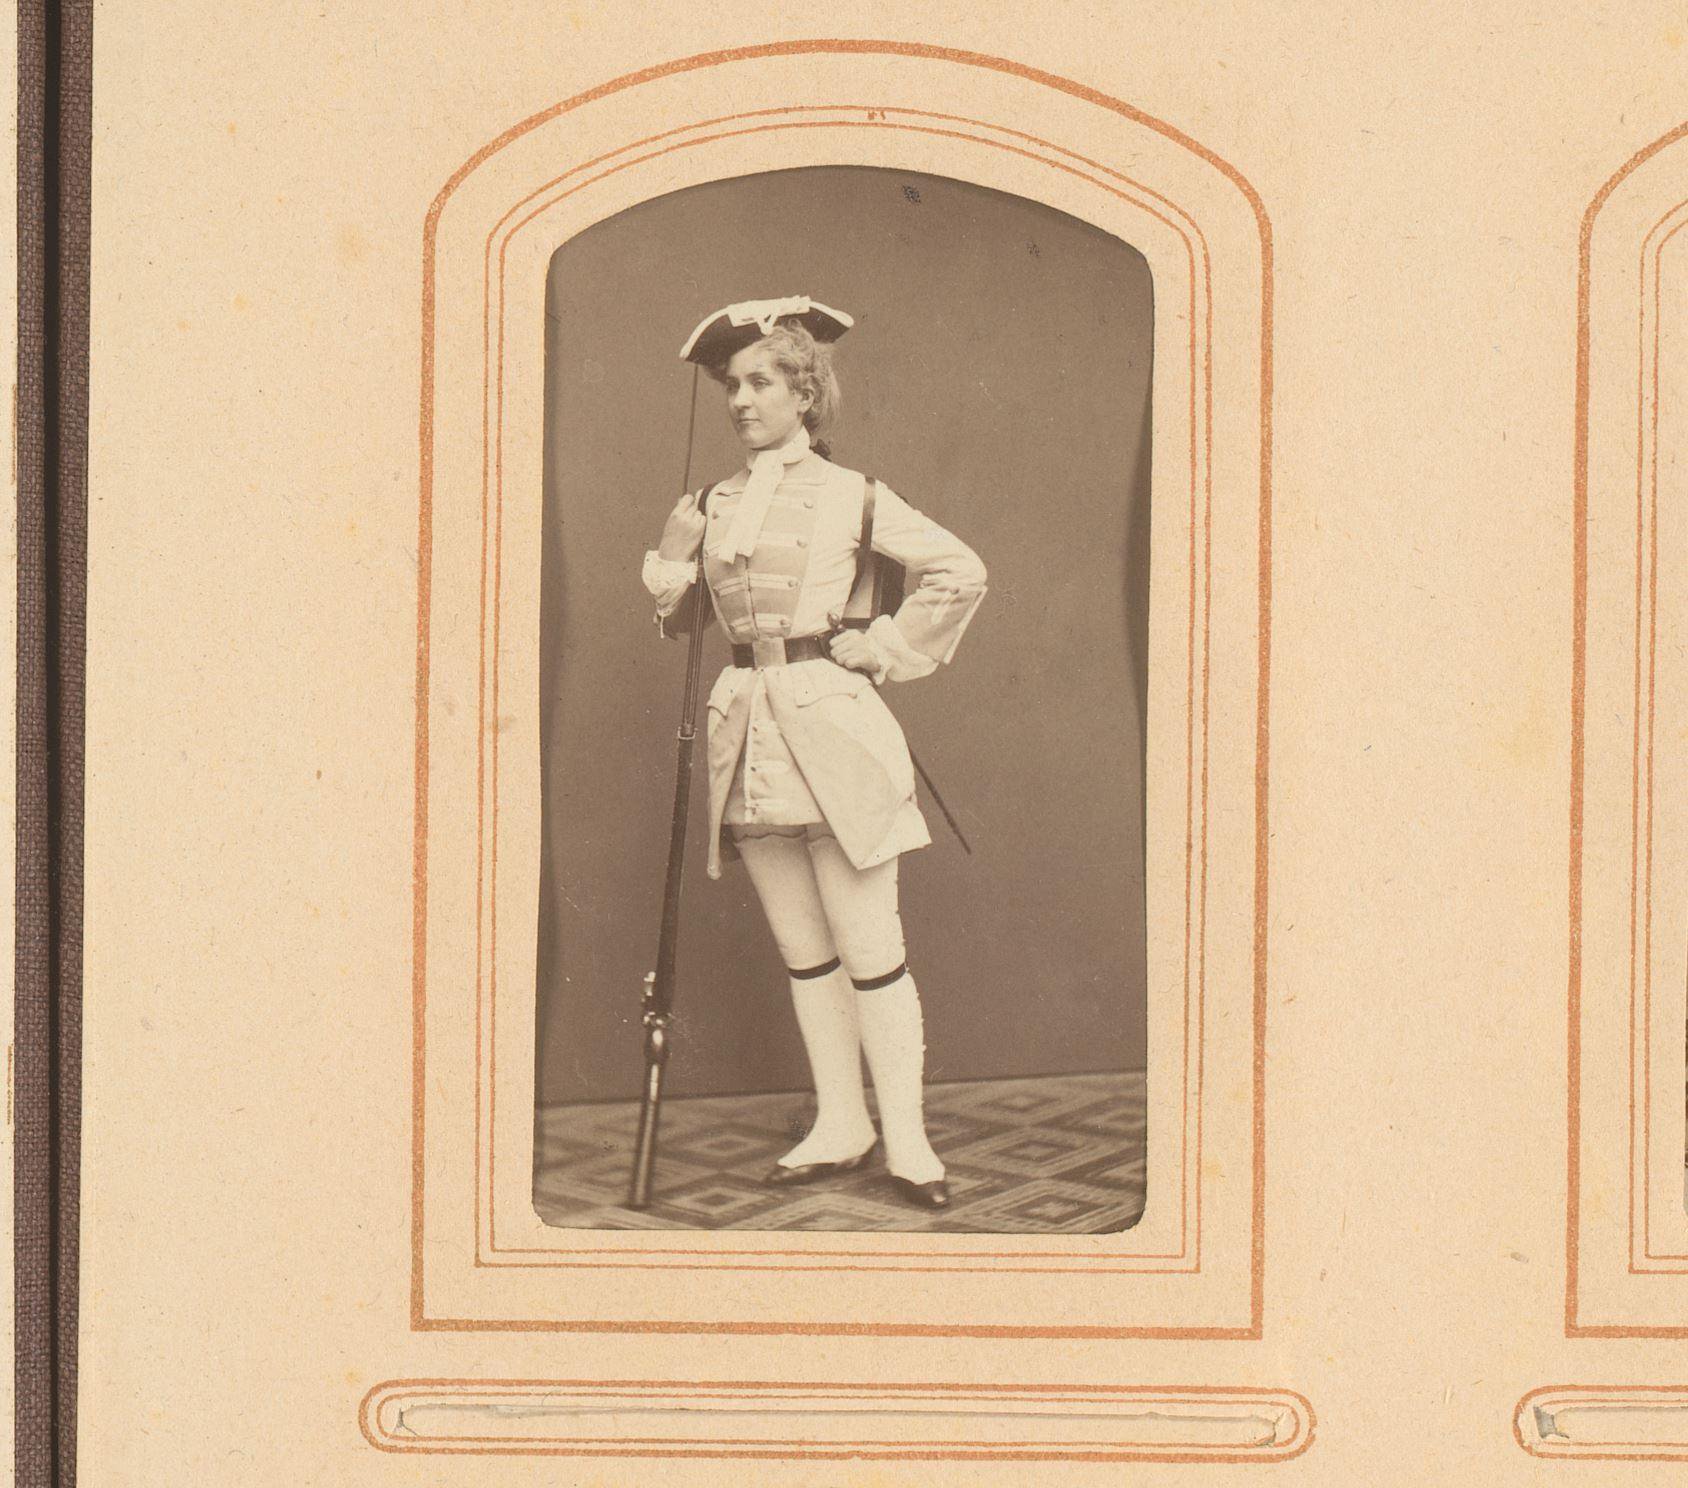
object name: carte de visite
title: Therese Bobey in kostuum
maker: gustav joop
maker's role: fotograaf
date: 1855-1890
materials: cardboard, photographic support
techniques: albumen print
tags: stage costume, historical persons, portrait of actor, actress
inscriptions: annotation: ‘Therese Bobey/ [...] Bjö[...]’, inscription: ‘Fotografi Atelier/ af/ Gust. Joop & Comp./ Stockholm/ Näckströmsgatan/ (...)’